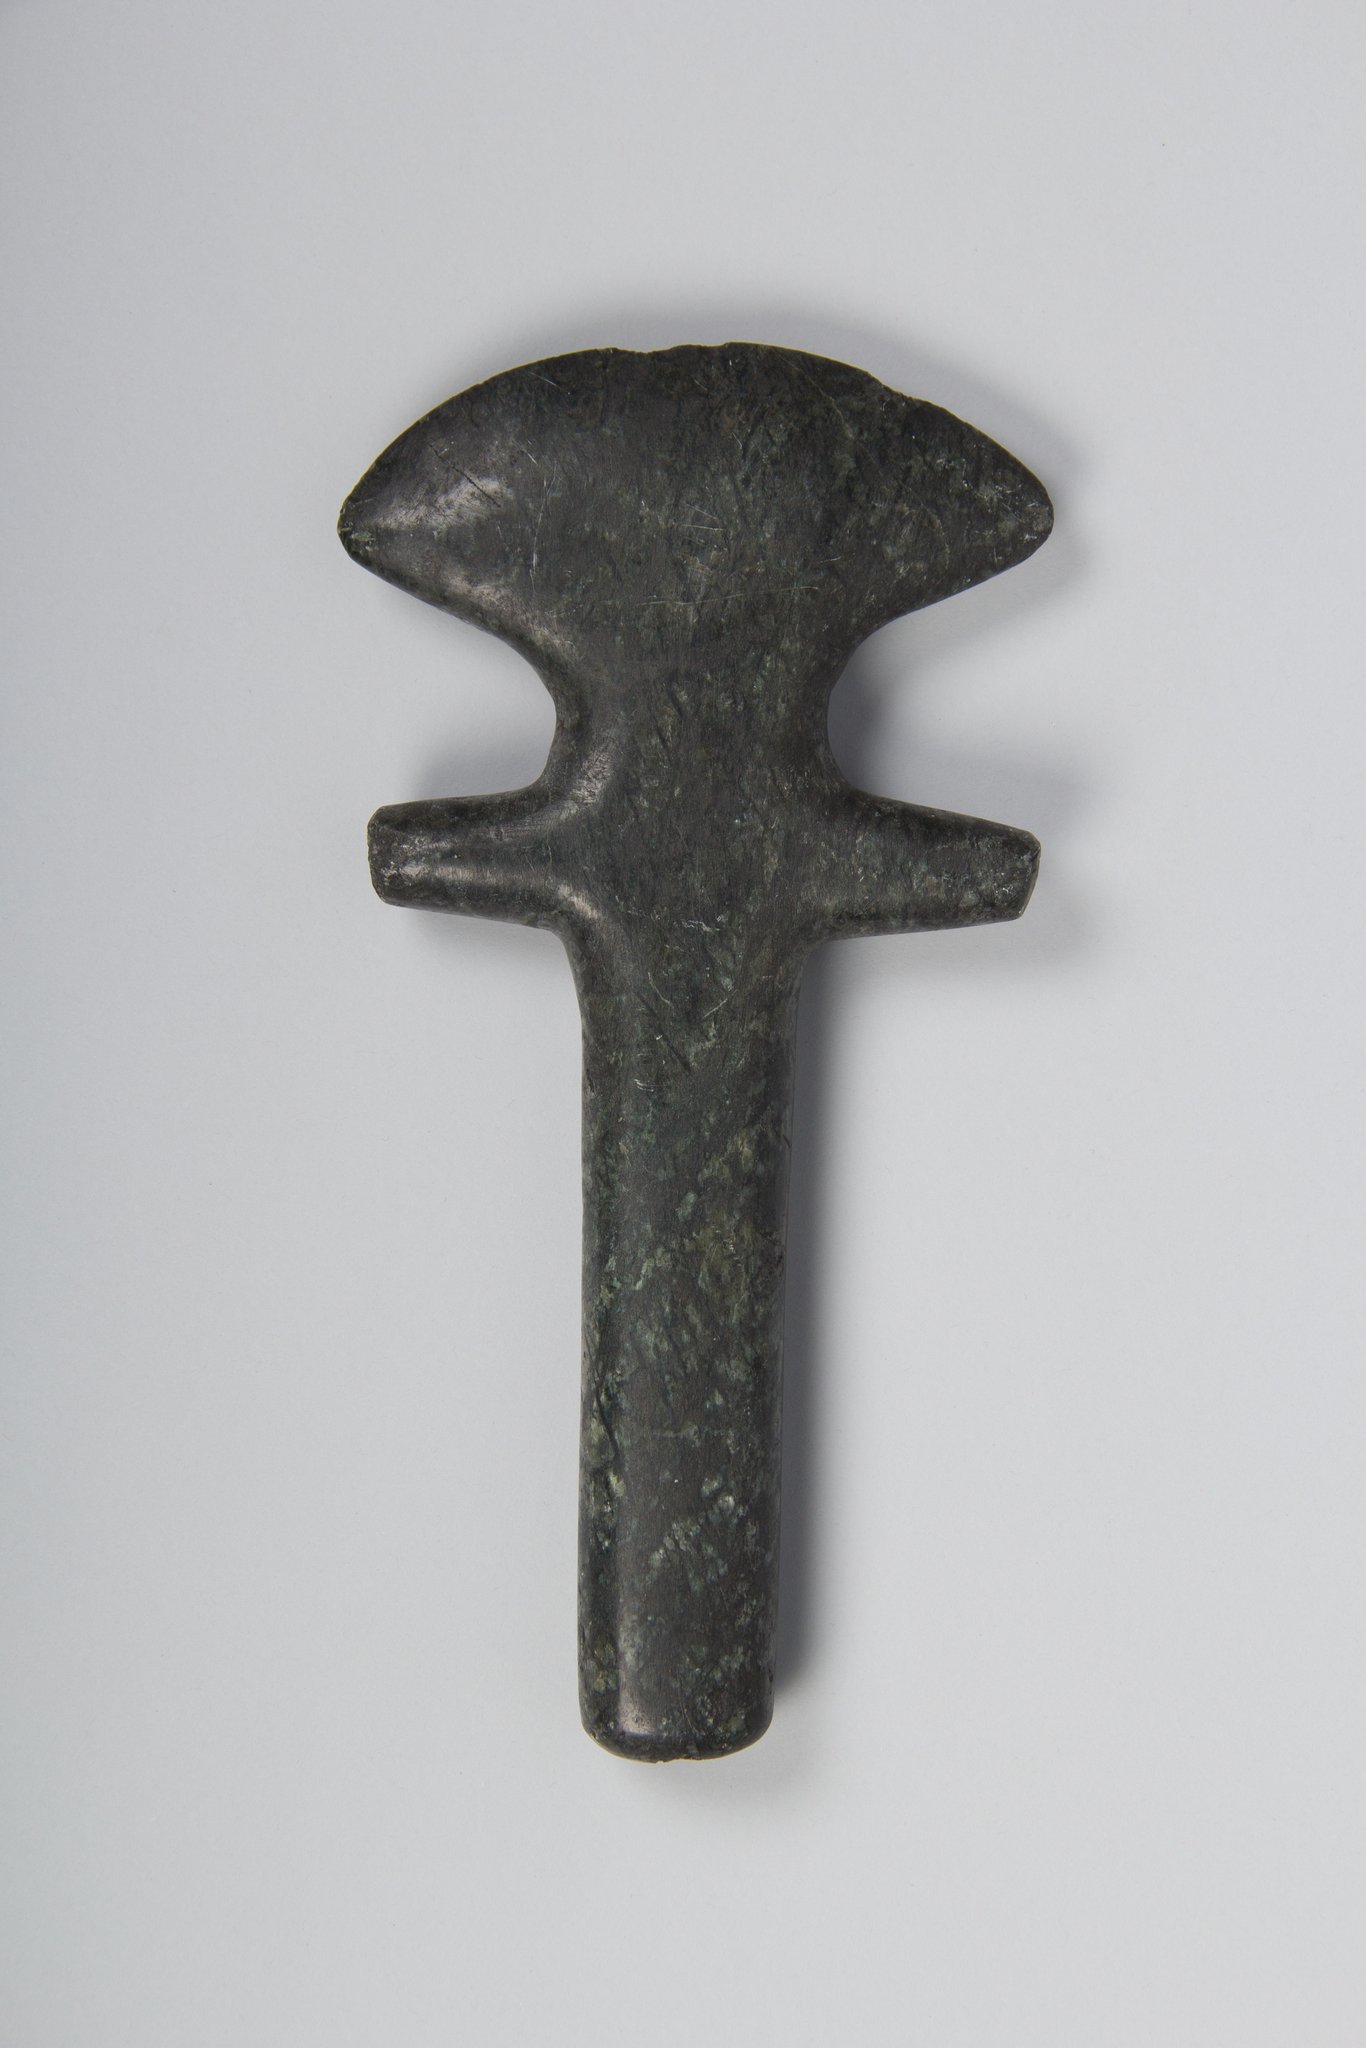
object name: ax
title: Stone Axe with Hornlike Protrusions (Yūkaku sekifu)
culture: japanese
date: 1000-250 BCE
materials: stone